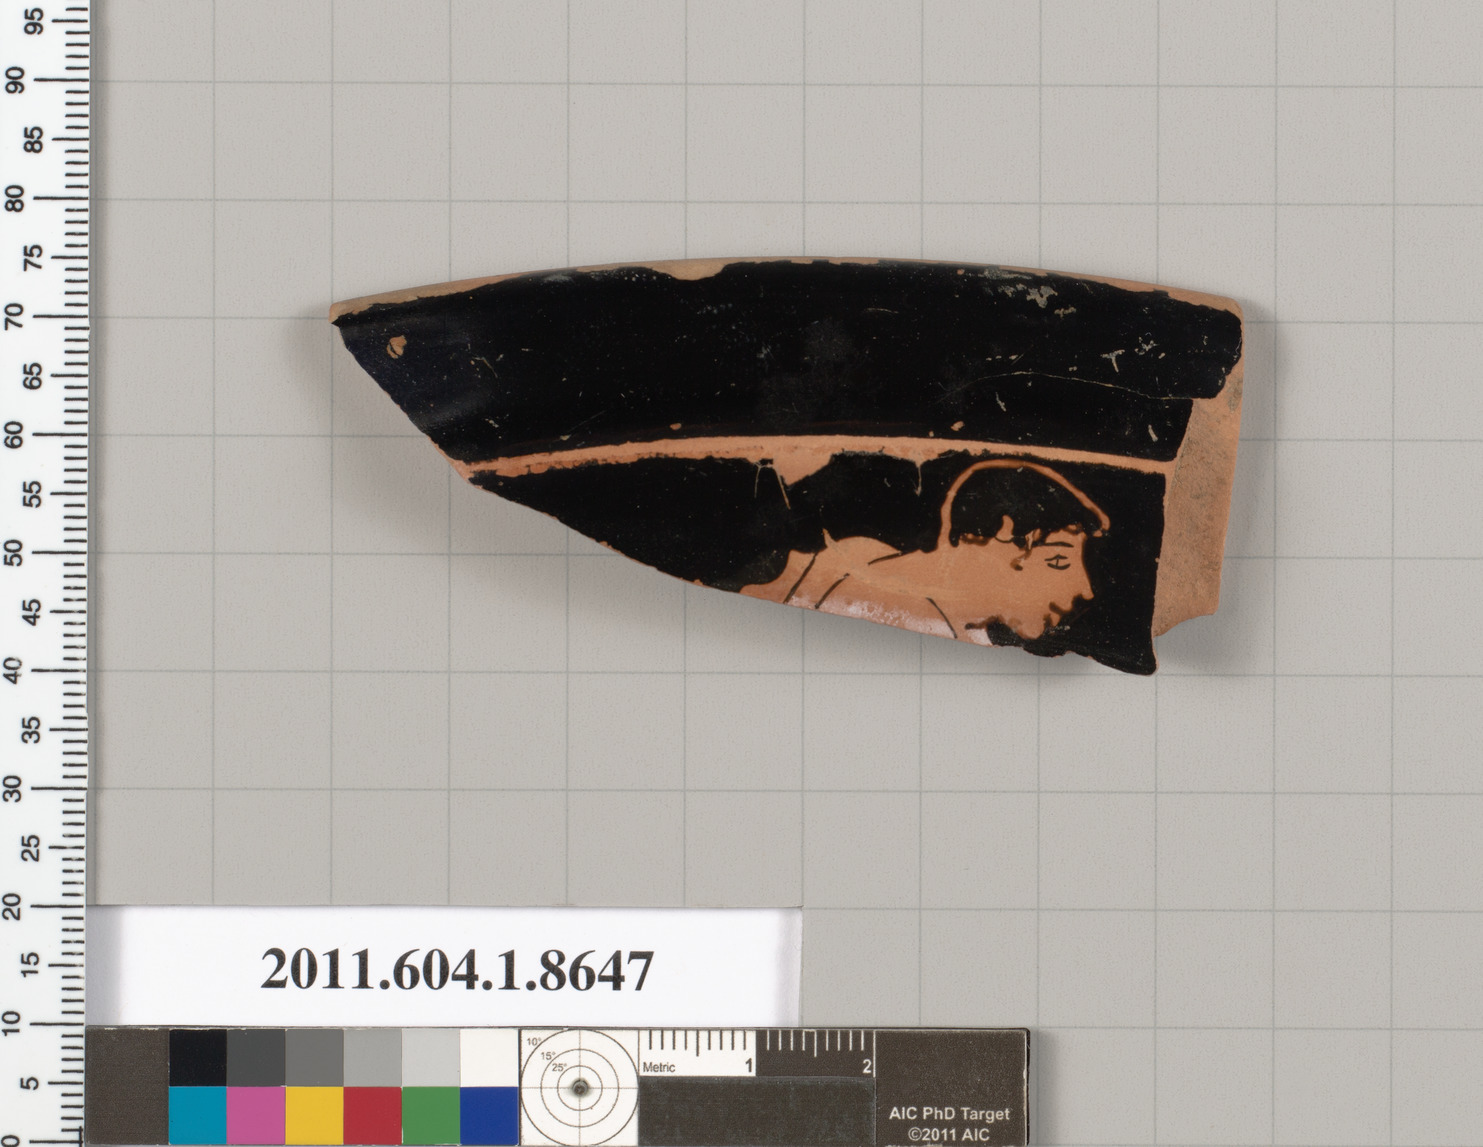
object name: kylix fragment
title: Terracotta rim fragment of a stemless? kylix (drinking cup)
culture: greek, attic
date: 460-450 BCE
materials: terracotta